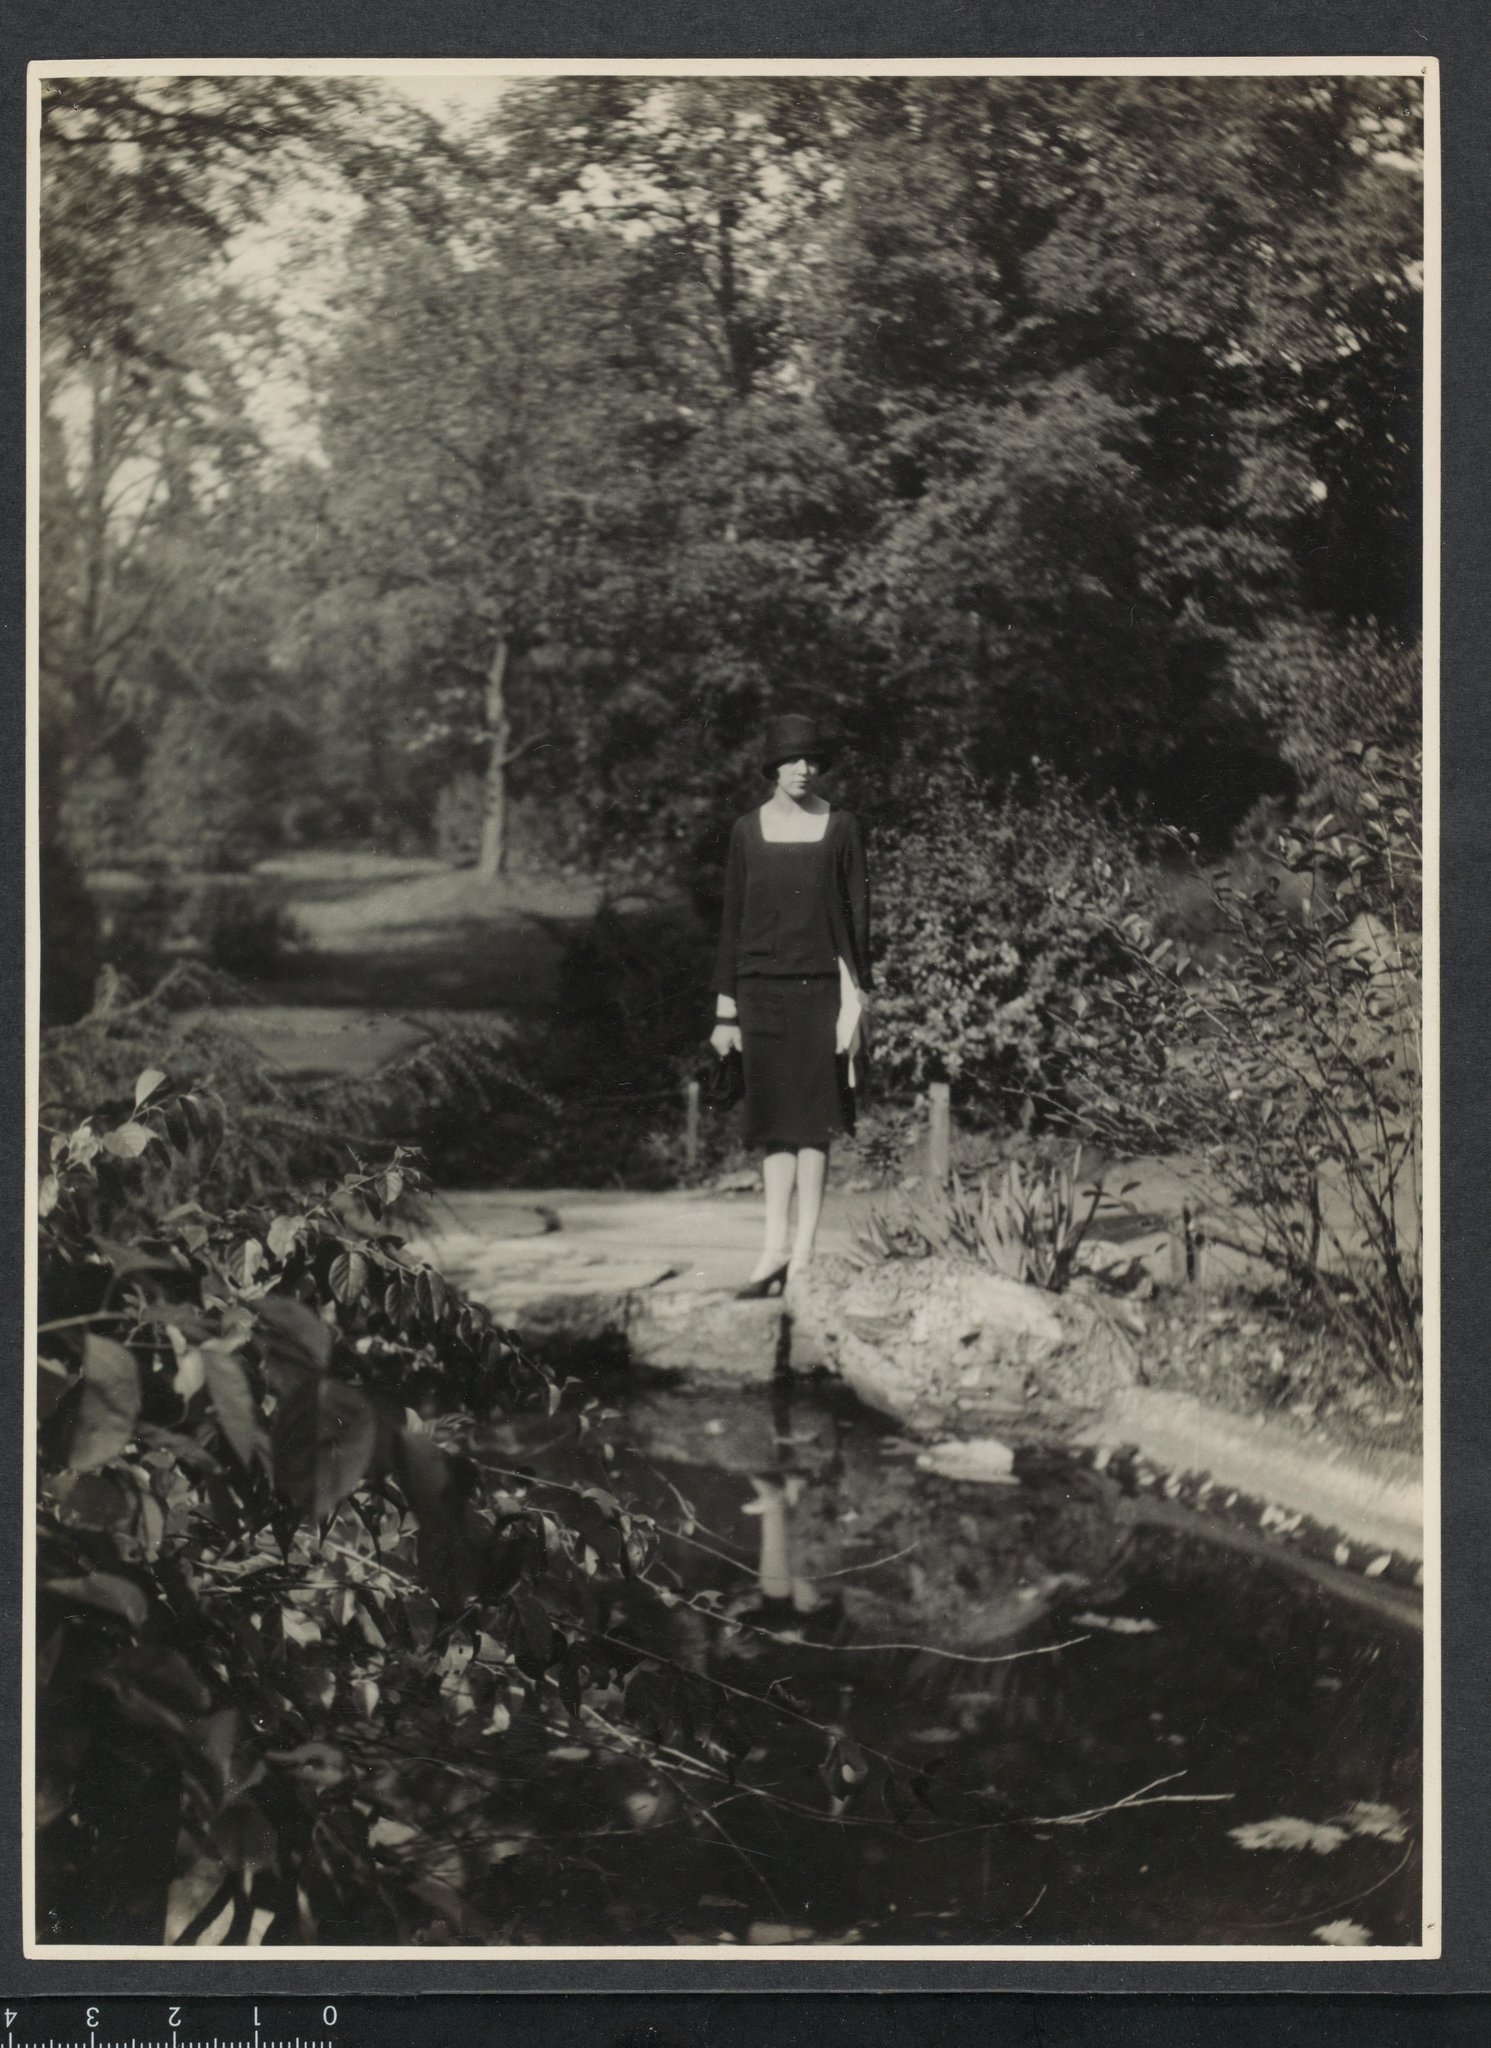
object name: photograph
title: Portret van G.A. Urtebise in een donkere jurk met pothoed staand bij een vijver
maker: Anonymous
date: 1920-1925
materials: photographic support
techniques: gelatin silver print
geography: belgium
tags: head-gear: hat, model, mannequin, dress, gown, belgium